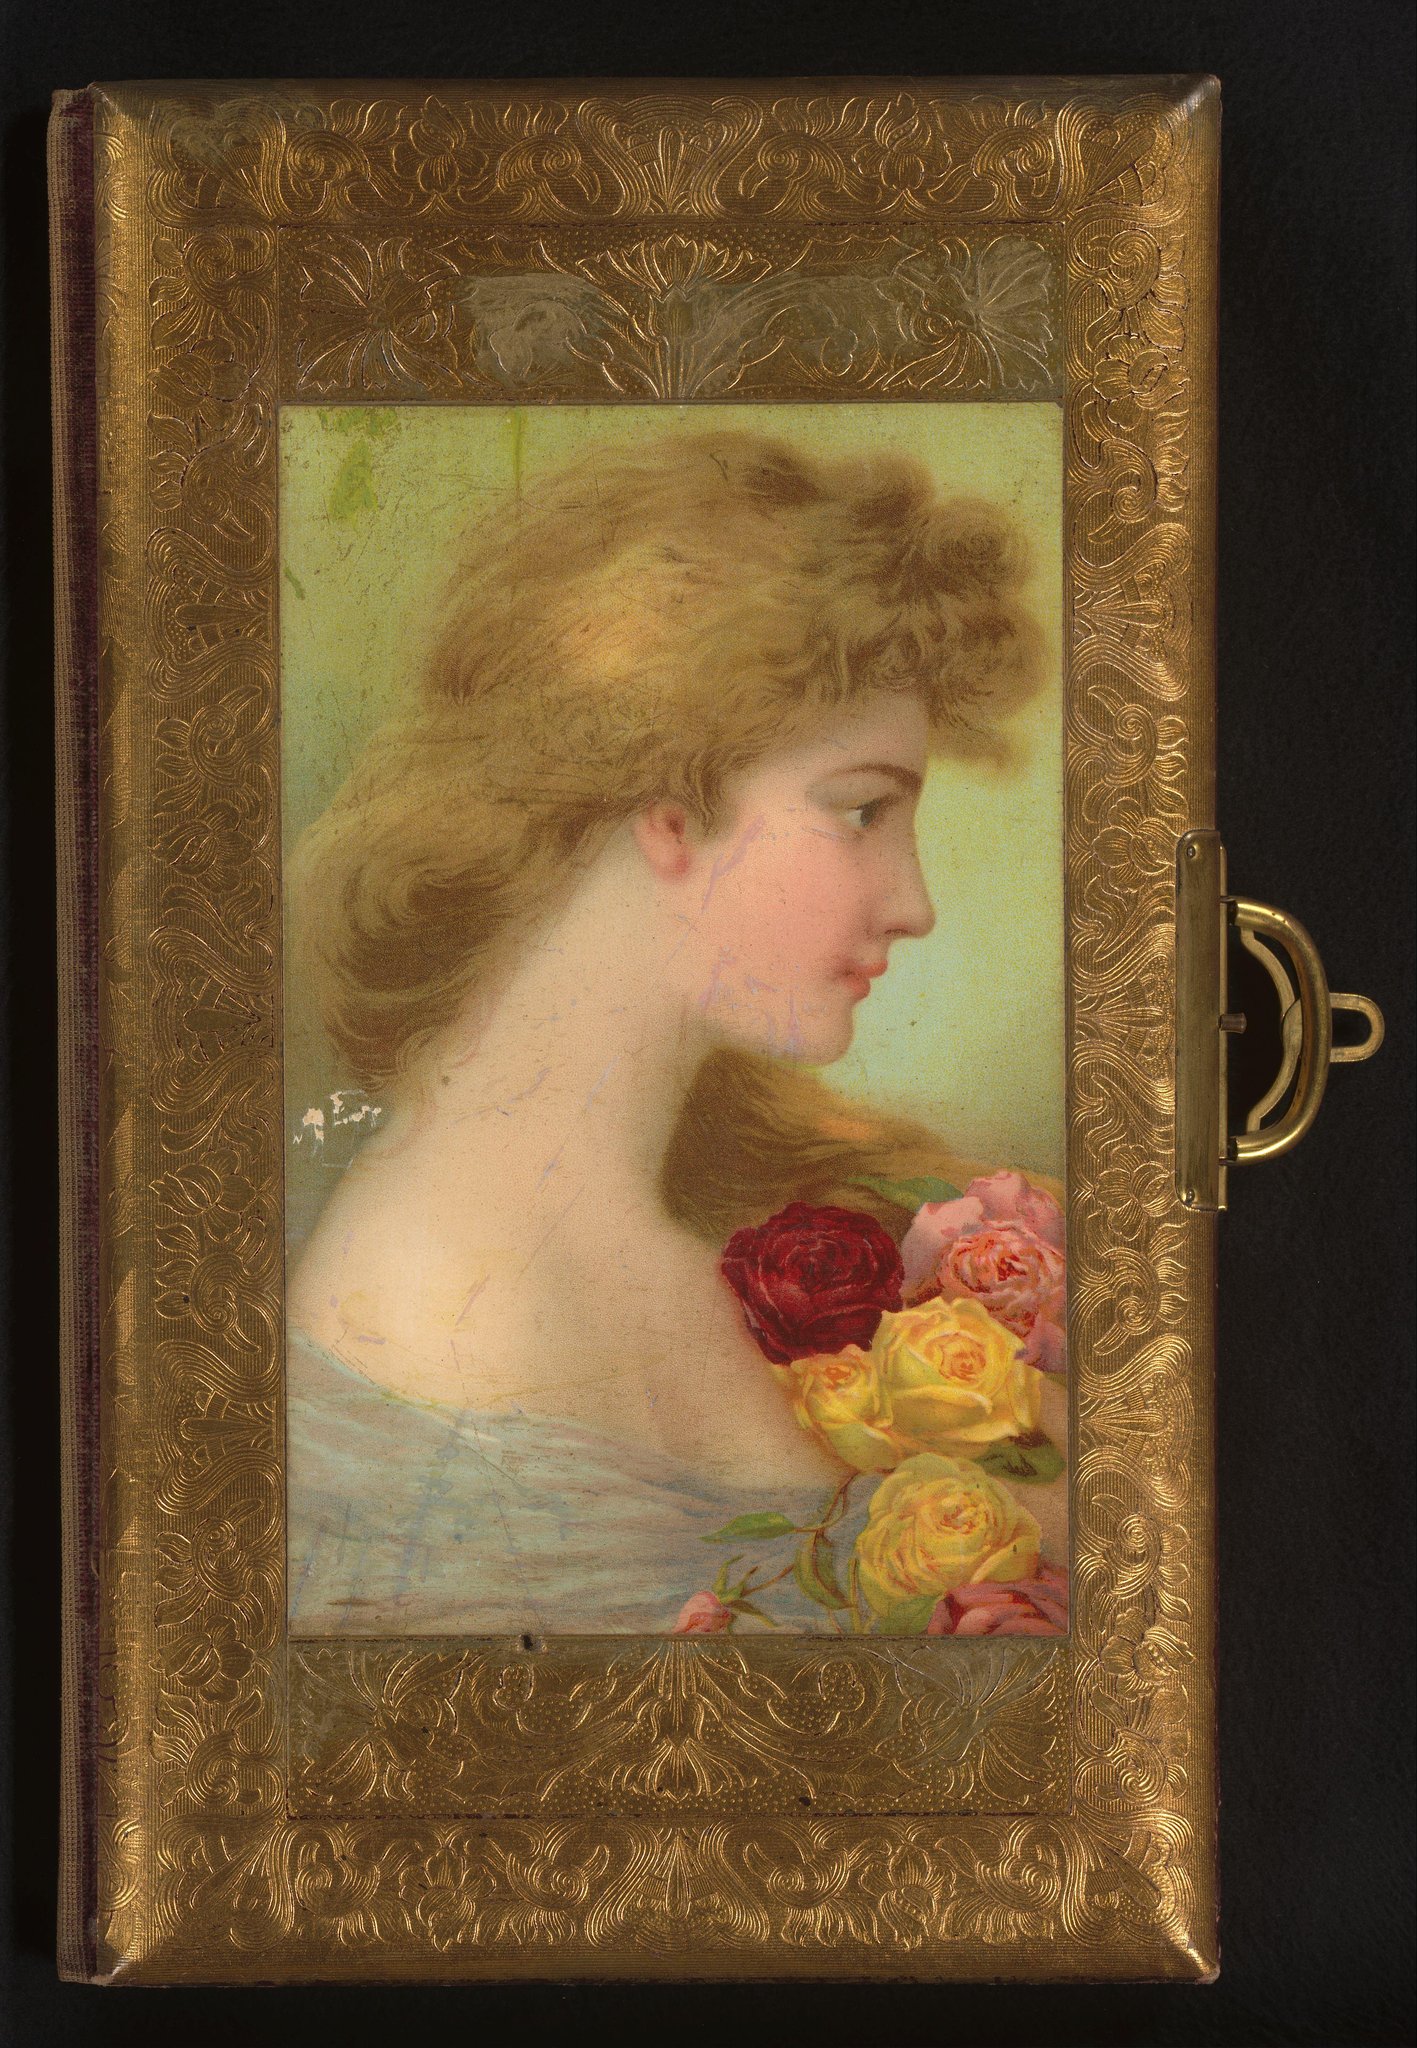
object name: slip in album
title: Nederlands familiealbum met 68 foto's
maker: Anonymous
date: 1860-1920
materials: cardboard, metal, paper, photographic support, textile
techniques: albumen print, ferrotyping, gelatin silver print, printing block, salted paper print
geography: netherlands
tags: historical persons - bb - woman, child, historical persons, forest, wood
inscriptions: collector's mark: ‘DIENST/ VERSPREIDE/ RIJKSKOLLEKTIES/ (...) A 982’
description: Fotoalbum met in totaal 68 foto's op 20 pagina's. Het album bevat 12 kabinetfoto's, 55 cartes-de-visite en 1 ferrotypie. Afgebeeld zijn portretten van onbekende mannen, vrouwen en kinderen en 2 fotoreproducties van schilderijen. De foto's zijn gemaakt door verschillende fotografen, waaronder de Nederlandse fotografen Albert Greiner en Max Büttinghausen. Van 25 foto's is de fotograaf anoniem.